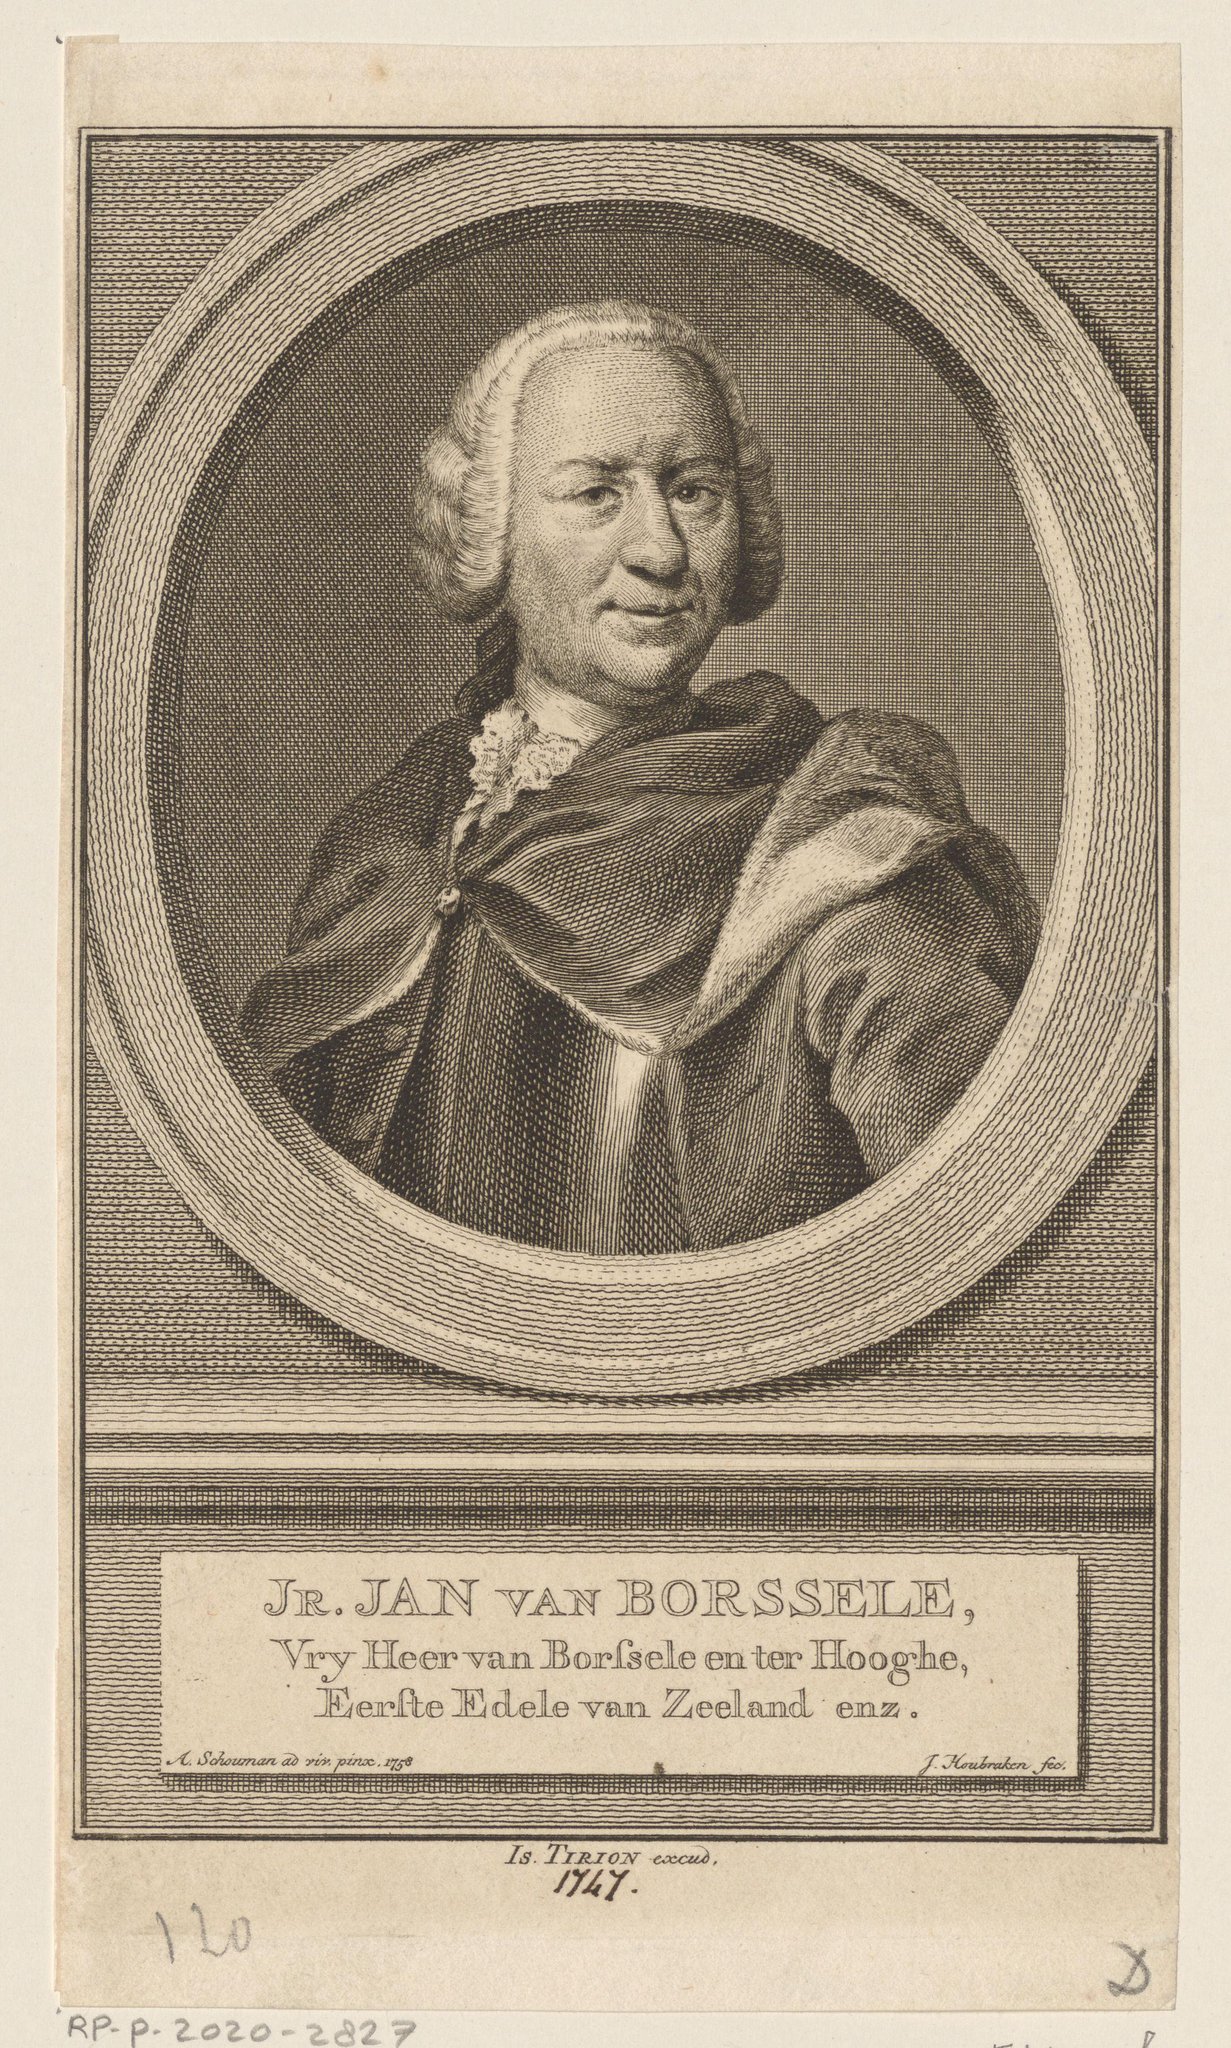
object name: print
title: Portret van Jan van Borssele van der Hooghe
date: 1758-1759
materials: paper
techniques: engraving, etching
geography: amsterdam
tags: historical persons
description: Prent voor het eerst verschenen in: Wagenaar, Jan. Vaderlandsche historie, vervattende de geschiedenissen der nu Vereenigde Nederlanden, inzonderheid die van Holland (...). 21 dln. Amsterdam: Isaak Tirion, 1749-1759, dl. 20. Prent ook gebruikt in latere edities van dit werk.